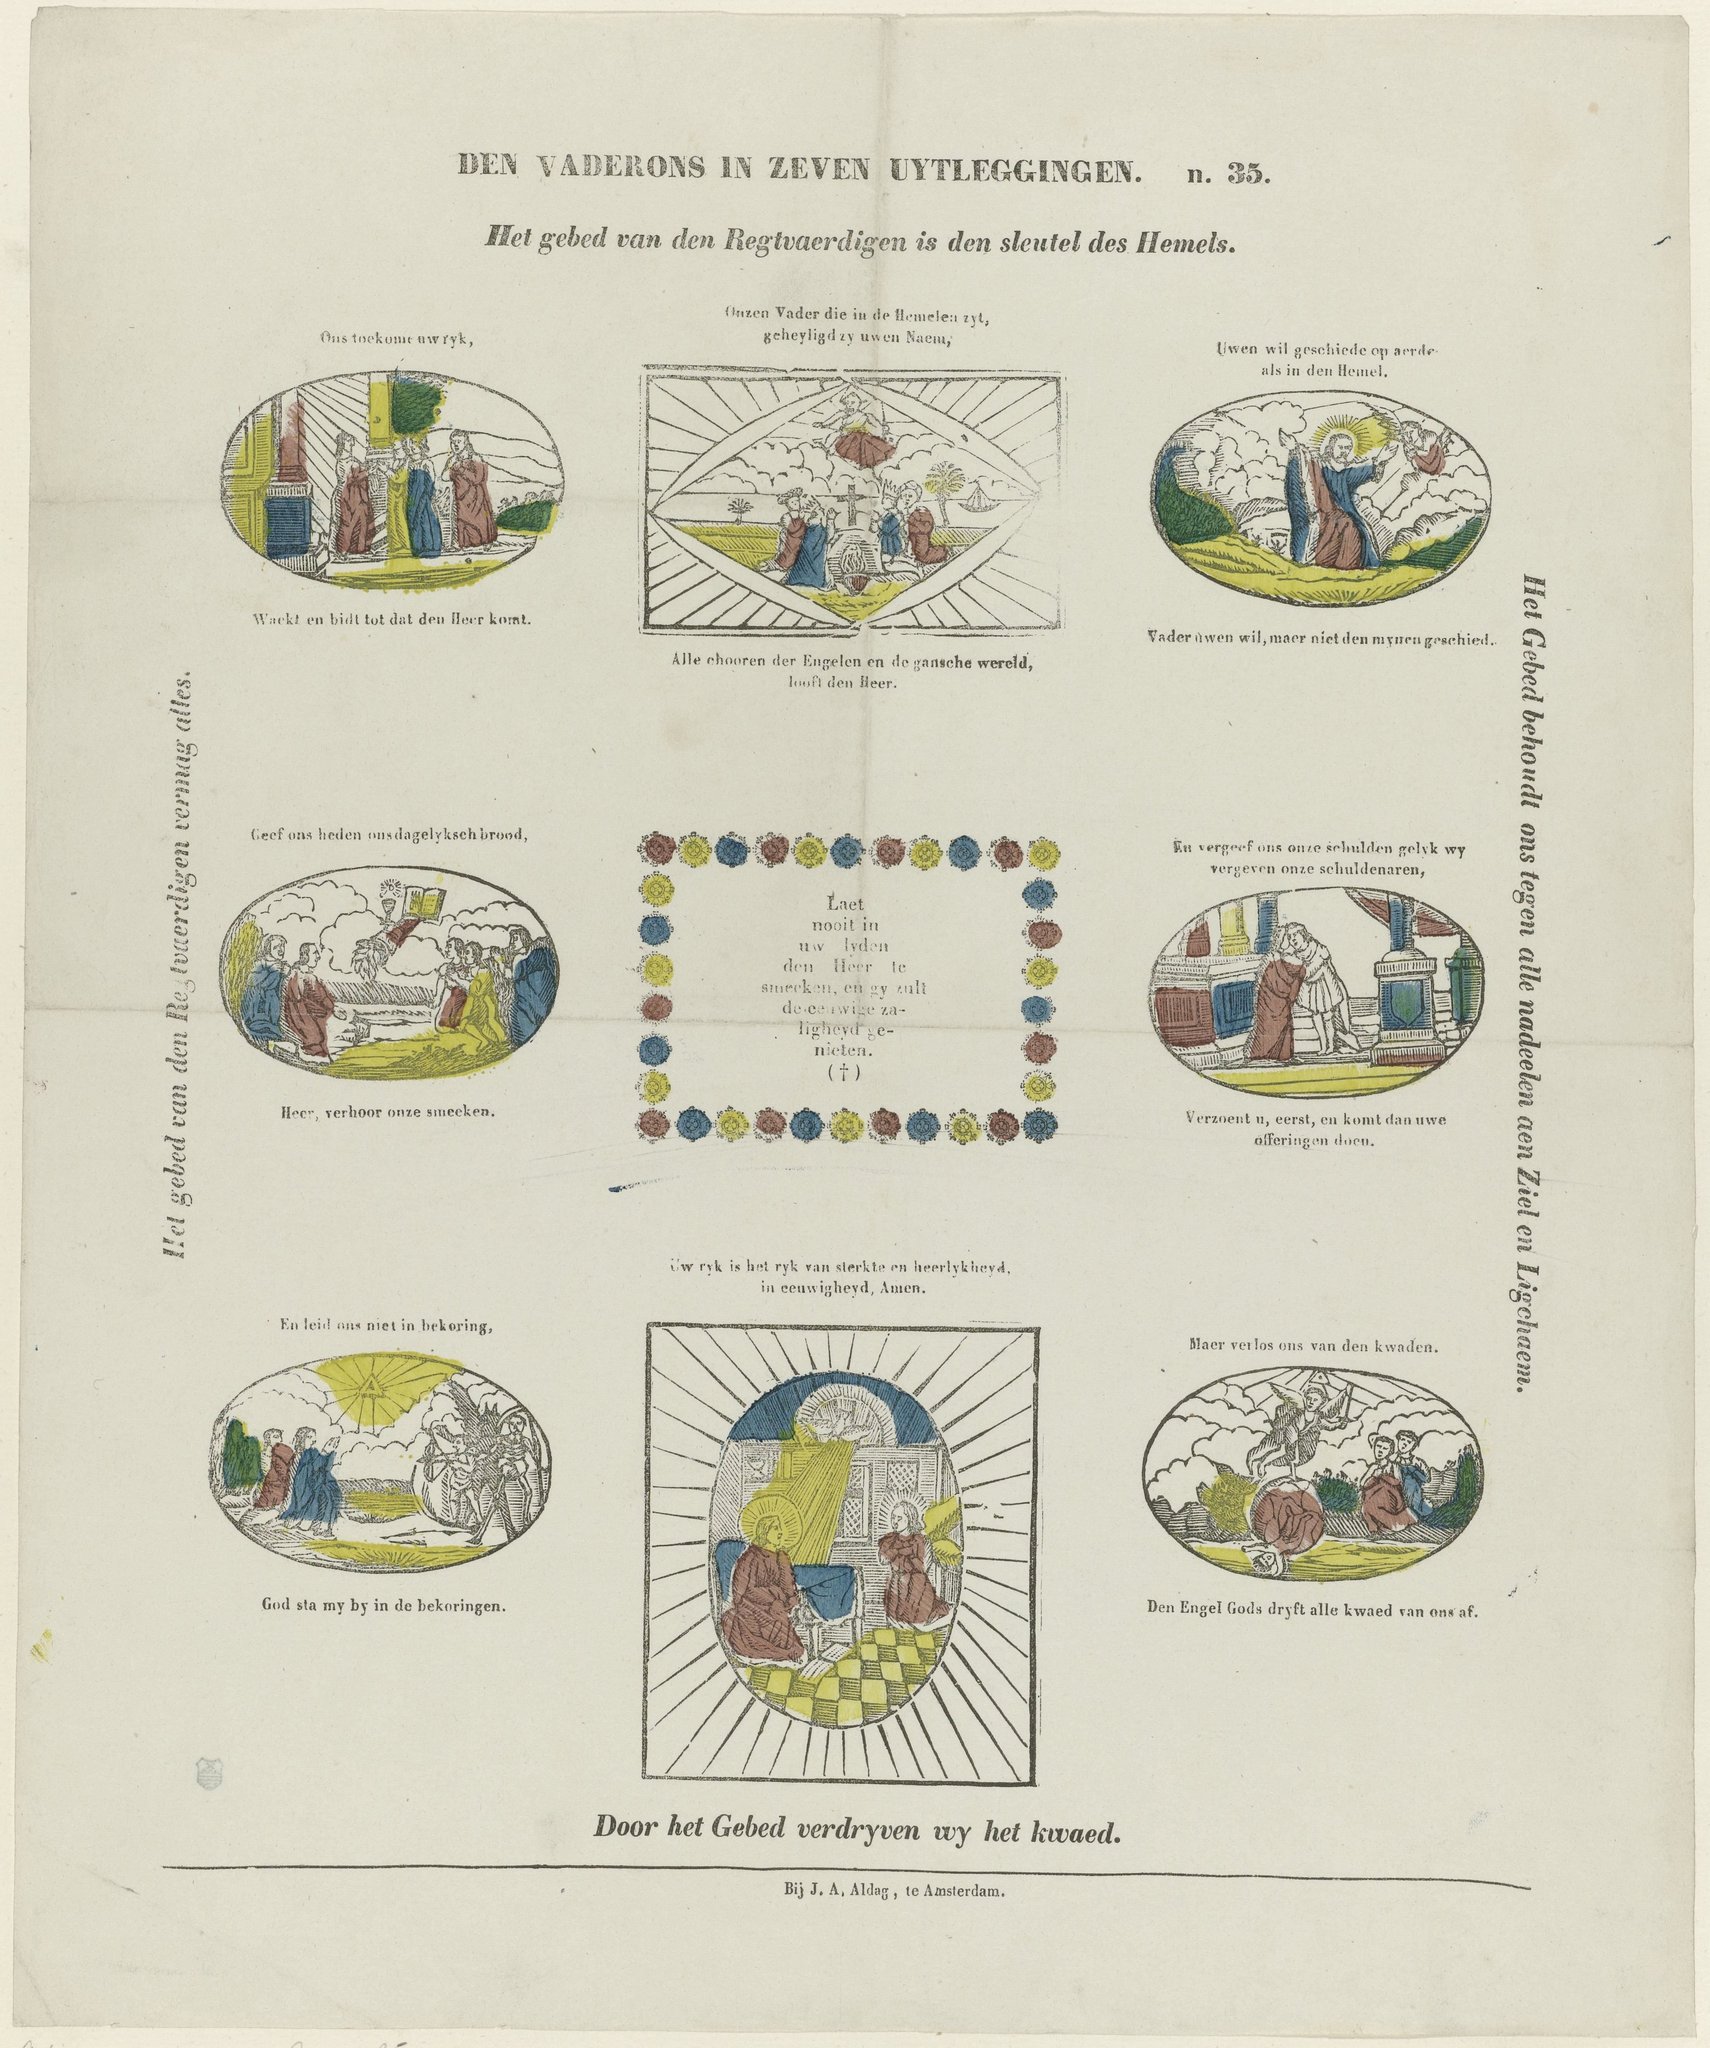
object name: print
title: Den Vaderons in zeven uitleggingen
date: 1833-1856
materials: paper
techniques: colour, letterpress printing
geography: turnhout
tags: the worship of god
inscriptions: collector's mark: Lugt 2760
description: Blad met 8 voorstellingen van biddende mensen. Bij elke afbeelding een onder- en bovenschrift. Genummerd rechtsboven: n. 35.